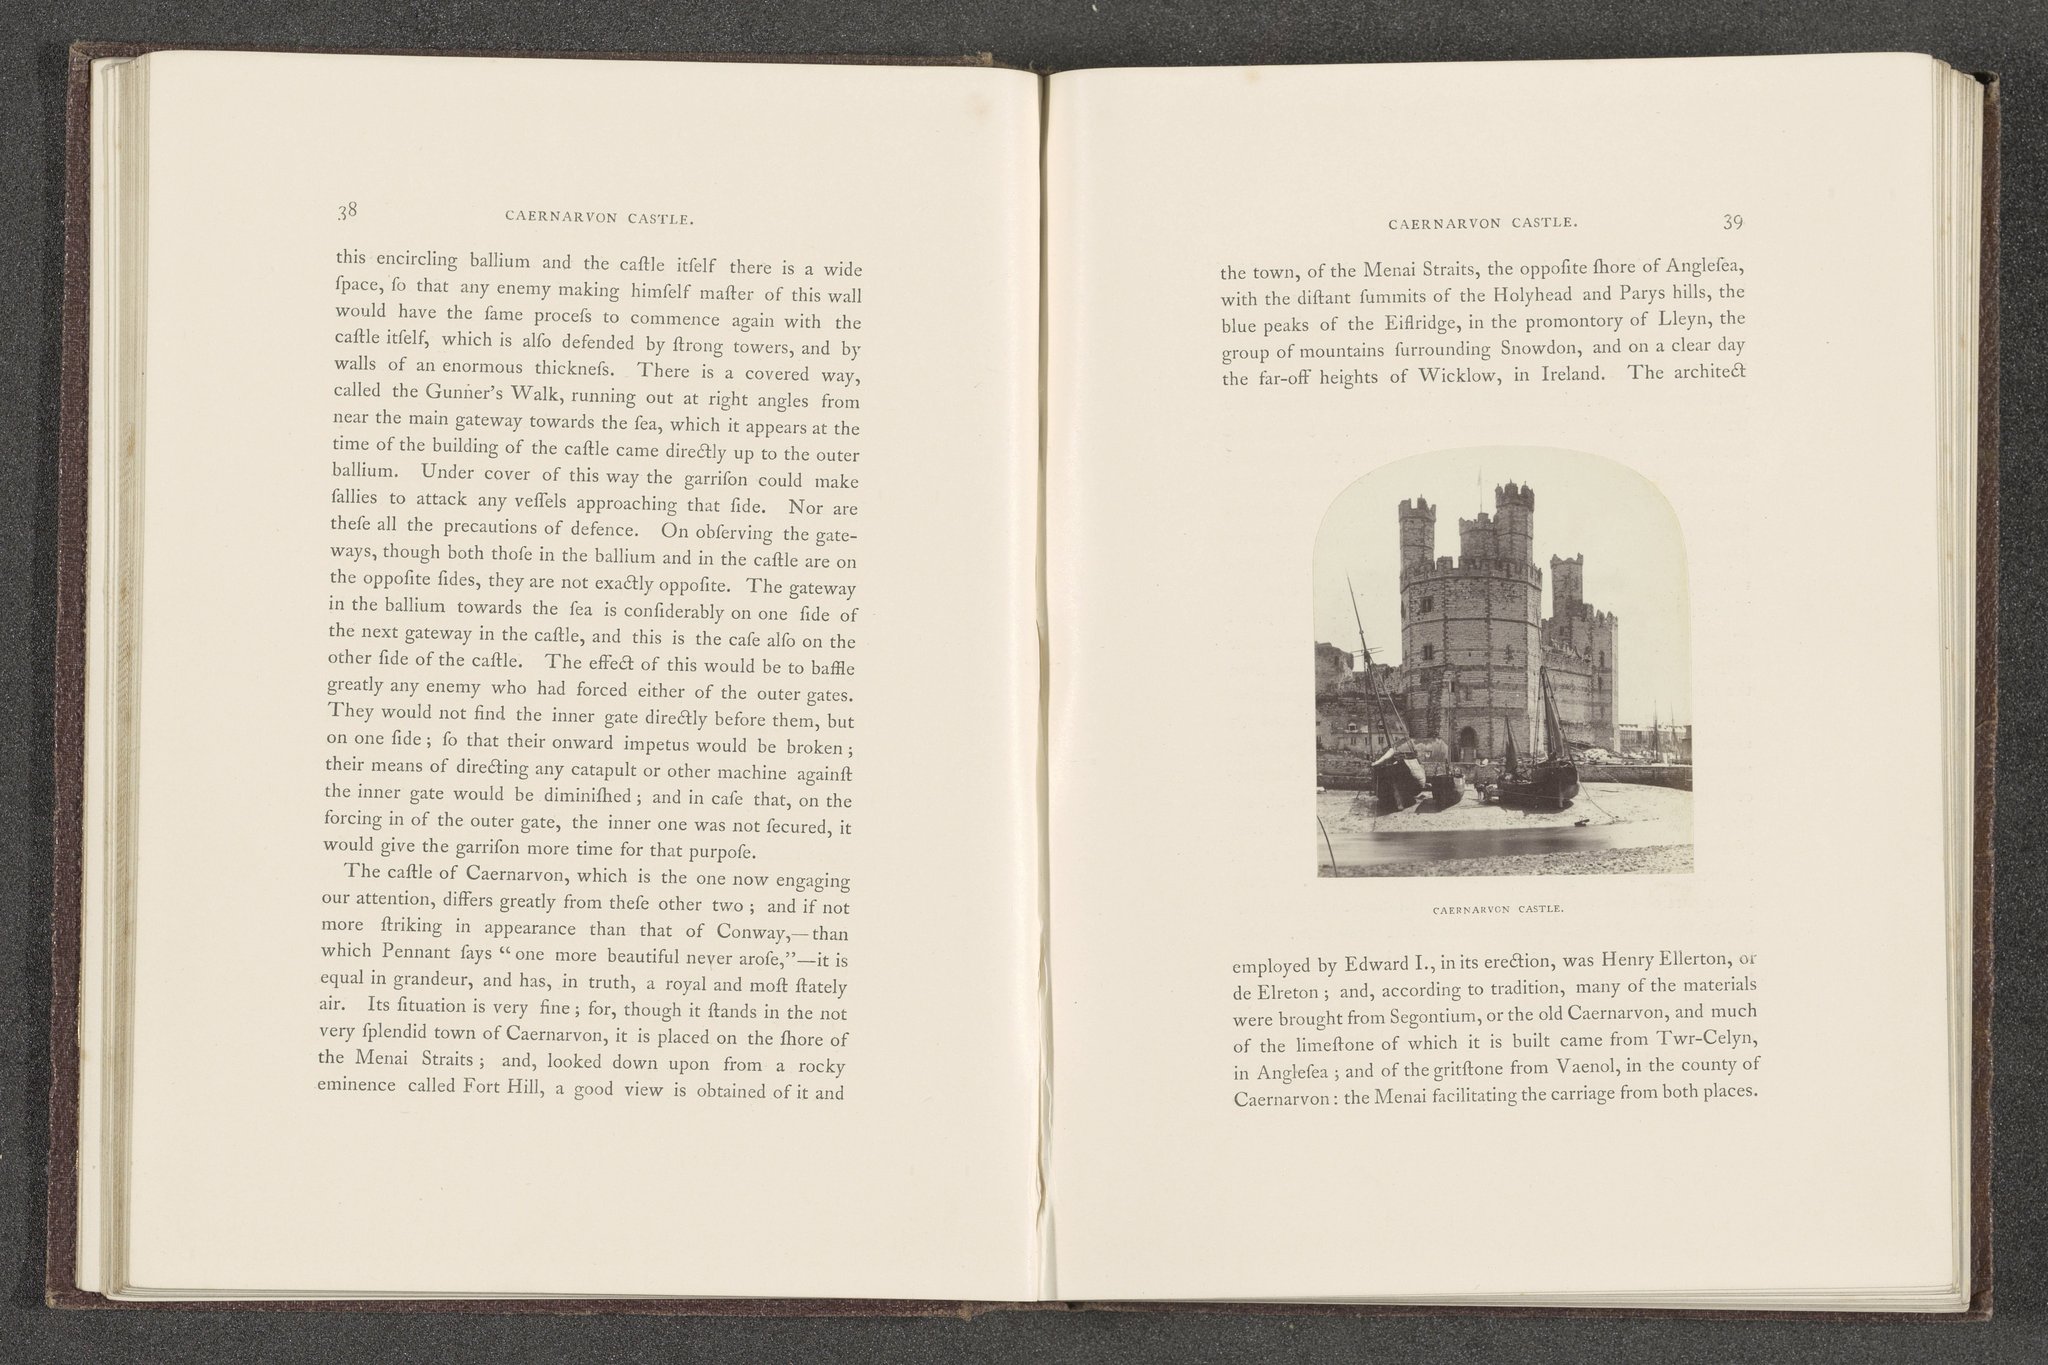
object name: photograph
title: Caernarvon Castle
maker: william russell sedgfield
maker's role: fotograaf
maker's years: 1826-1902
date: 1854-1864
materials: photographic support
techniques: albumen print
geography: caernarfon castle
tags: ruin of a dwelling, house, castle, etc.